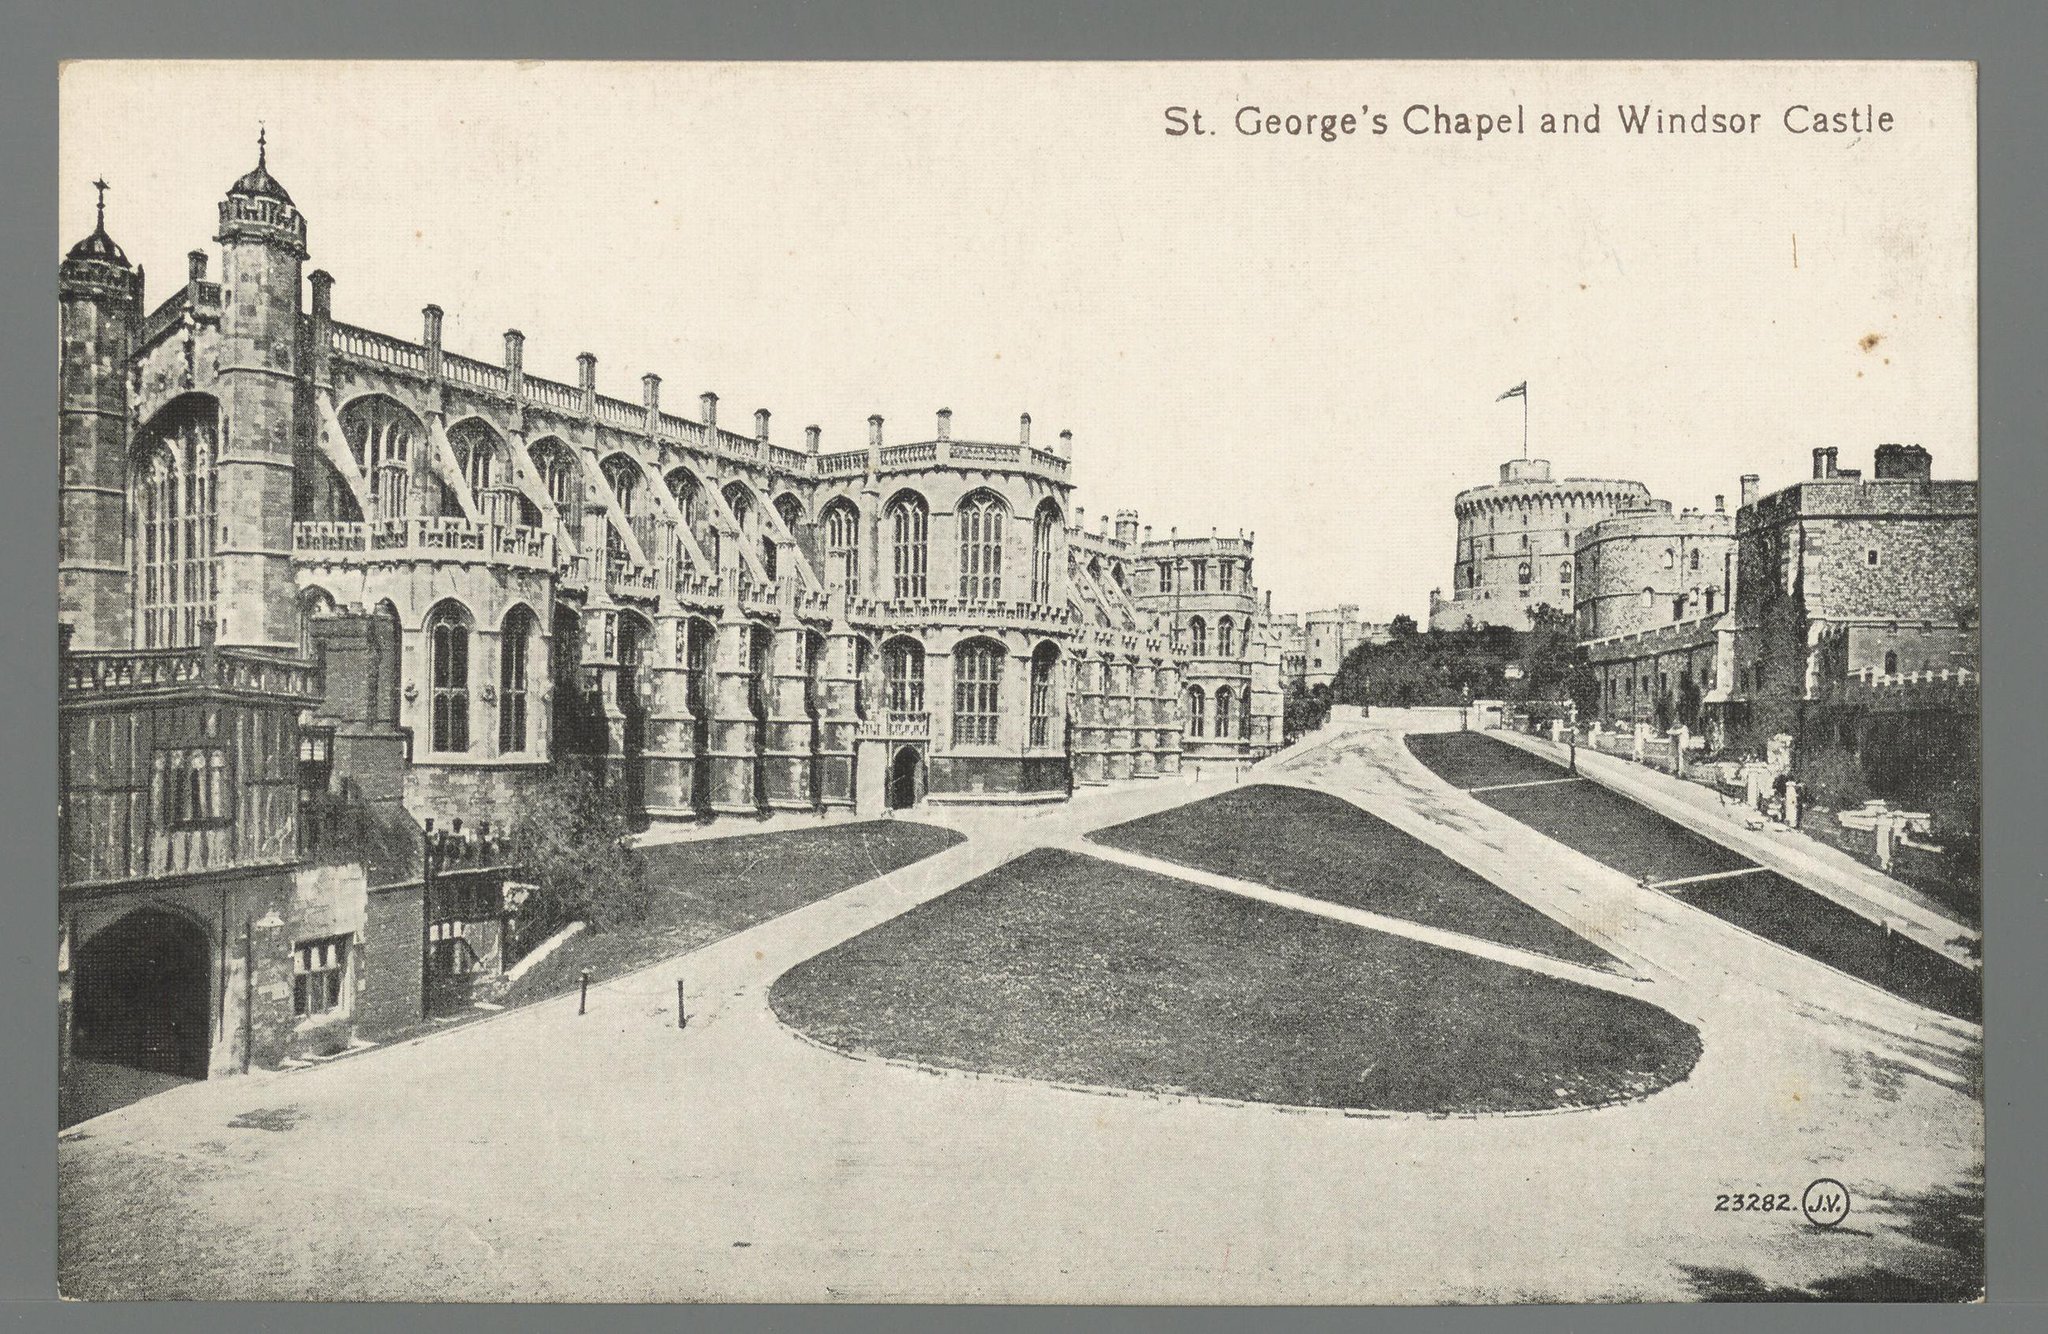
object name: ansichtkaart, prentbriefkaart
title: St. George's Chapel and Windsor Castle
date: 1902-1930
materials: cardboard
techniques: autotype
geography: great britain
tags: castle, church (exterior) - qq - small church, chapel